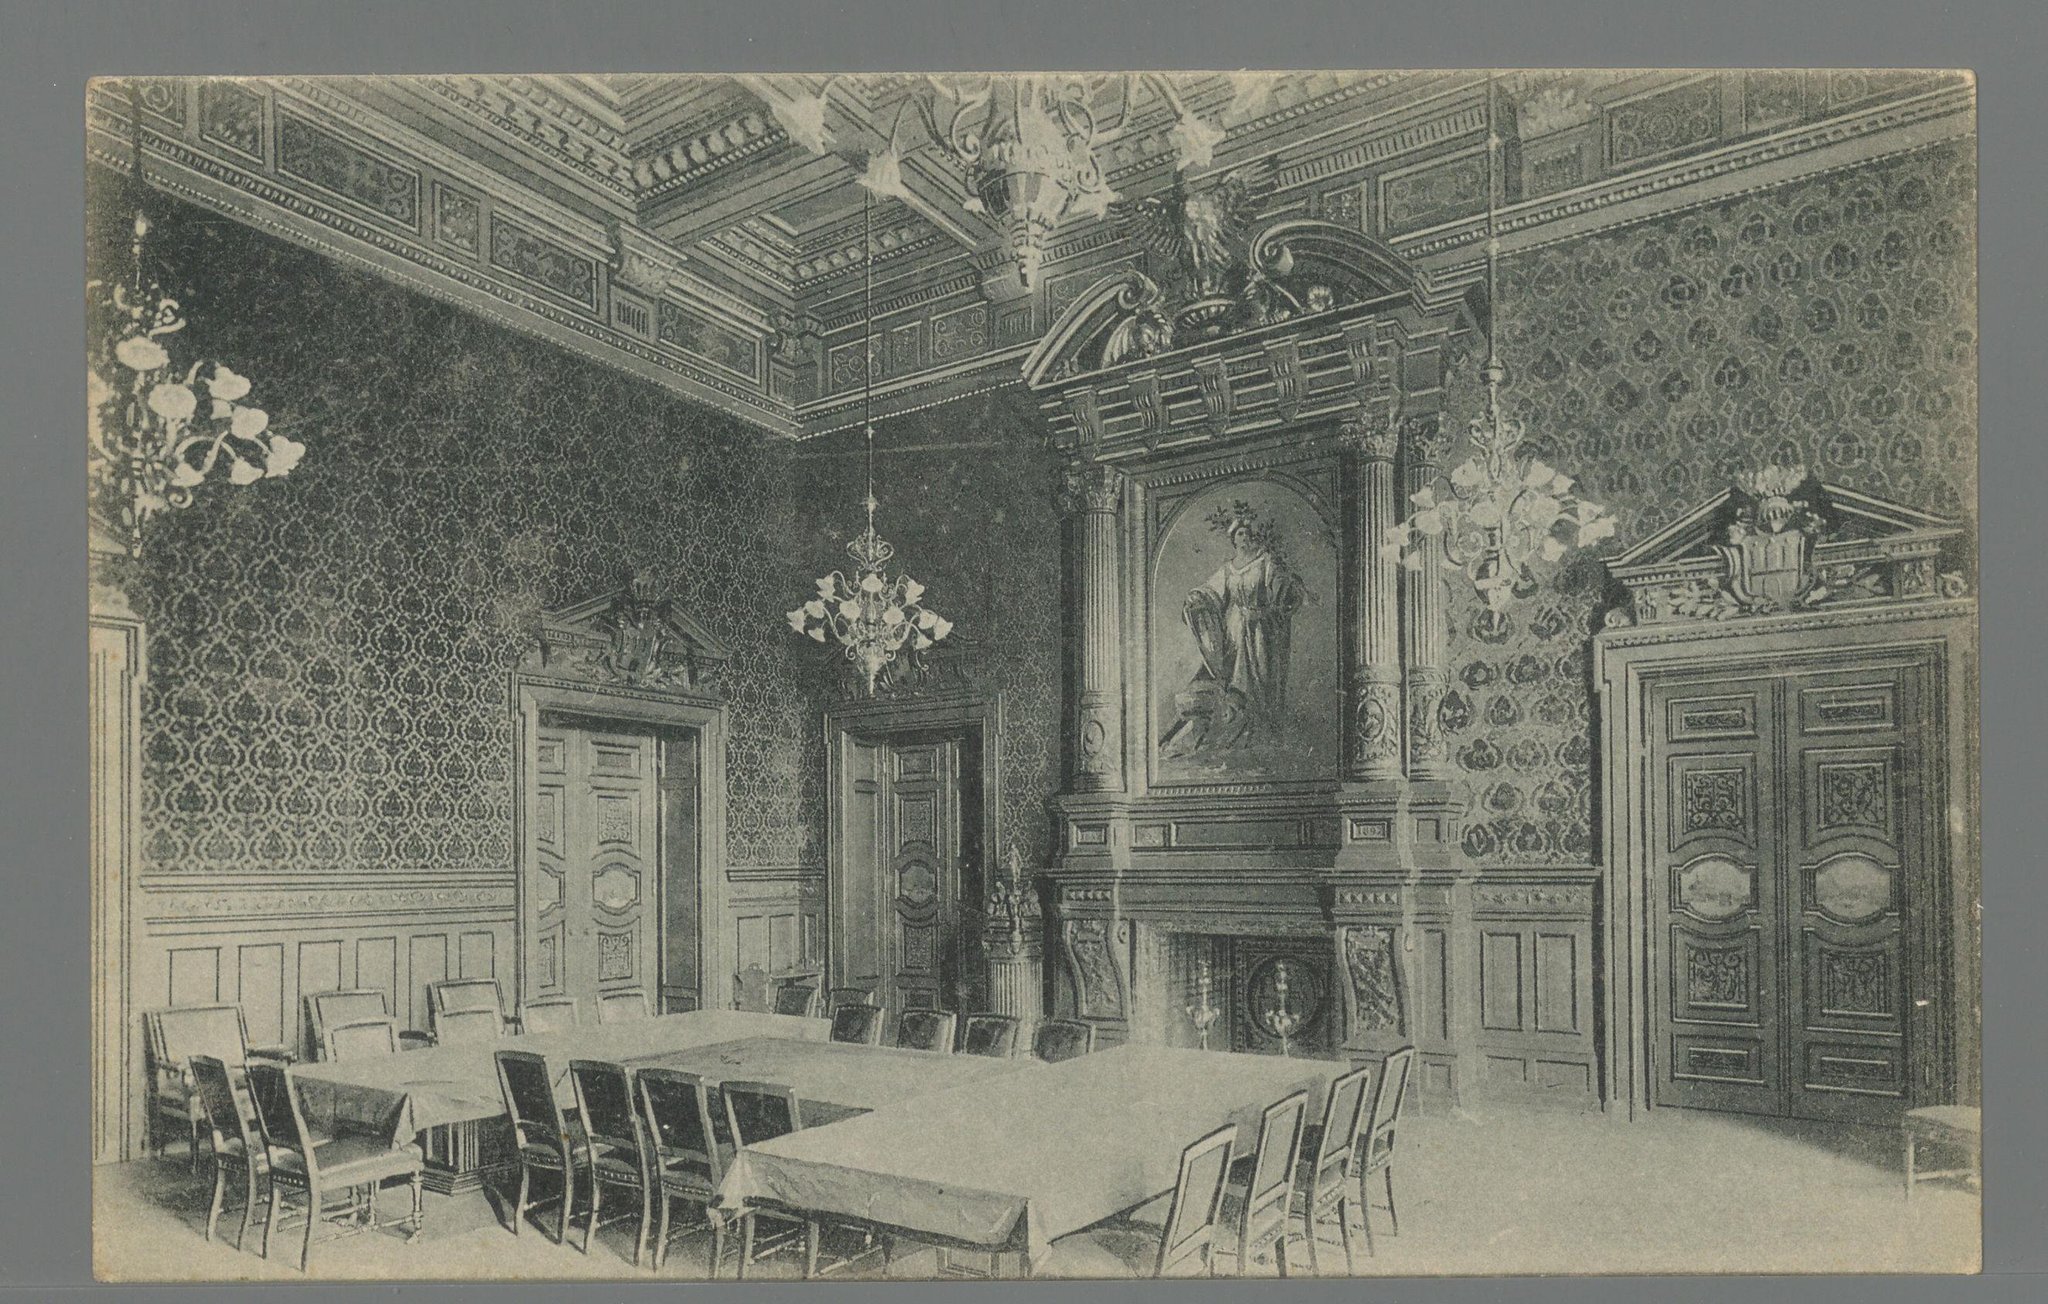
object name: ansichtkaart, prentbriefkaart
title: Hamburg, Rathaus. Phönixsaal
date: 1906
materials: cardboard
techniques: photograph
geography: hamburg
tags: townhall, interior of the house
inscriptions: date